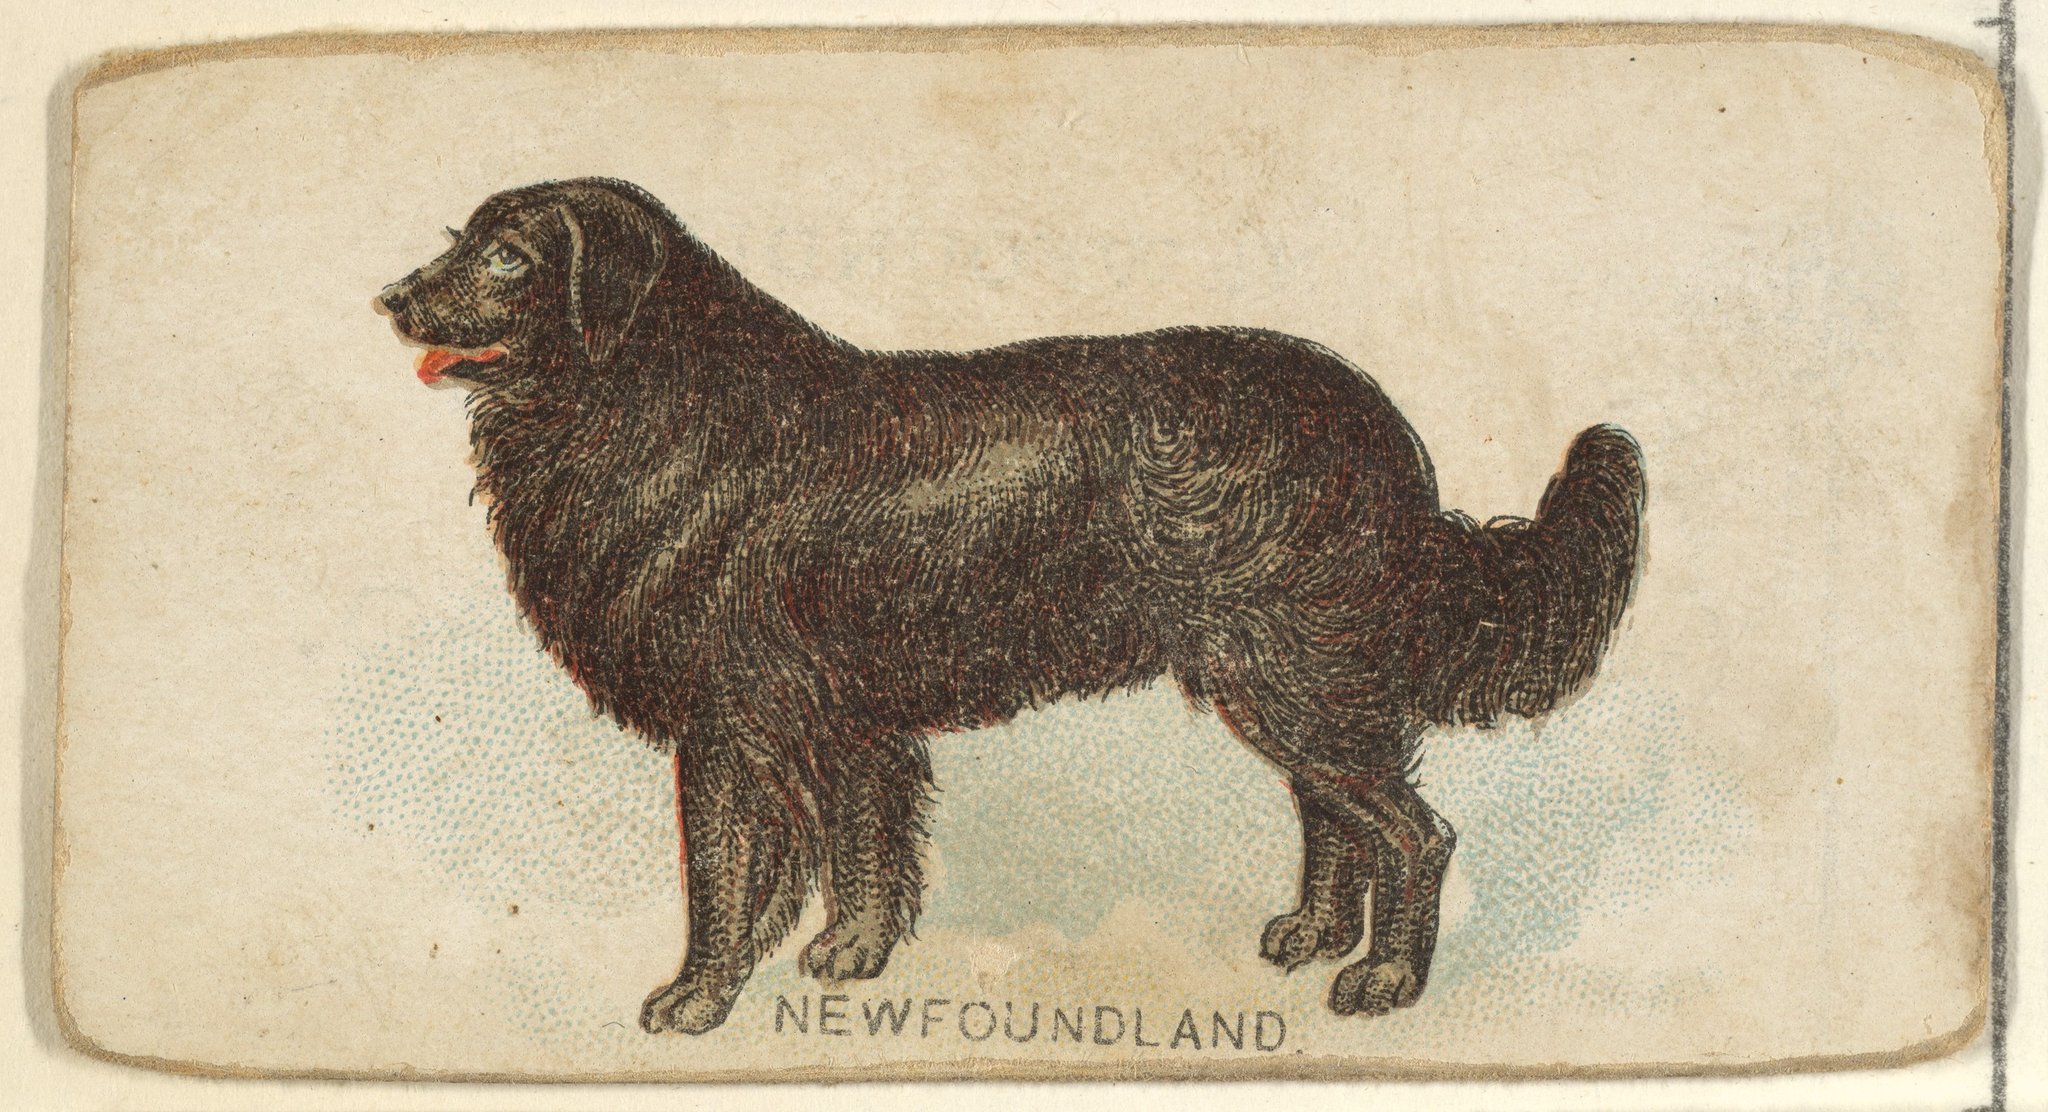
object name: print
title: Newfoundland, from the Dogs of the World series for Old Judge Cigarettes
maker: goodwin & company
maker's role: publisher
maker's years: 1850-1950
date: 1890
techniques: color lithograph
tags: dogs